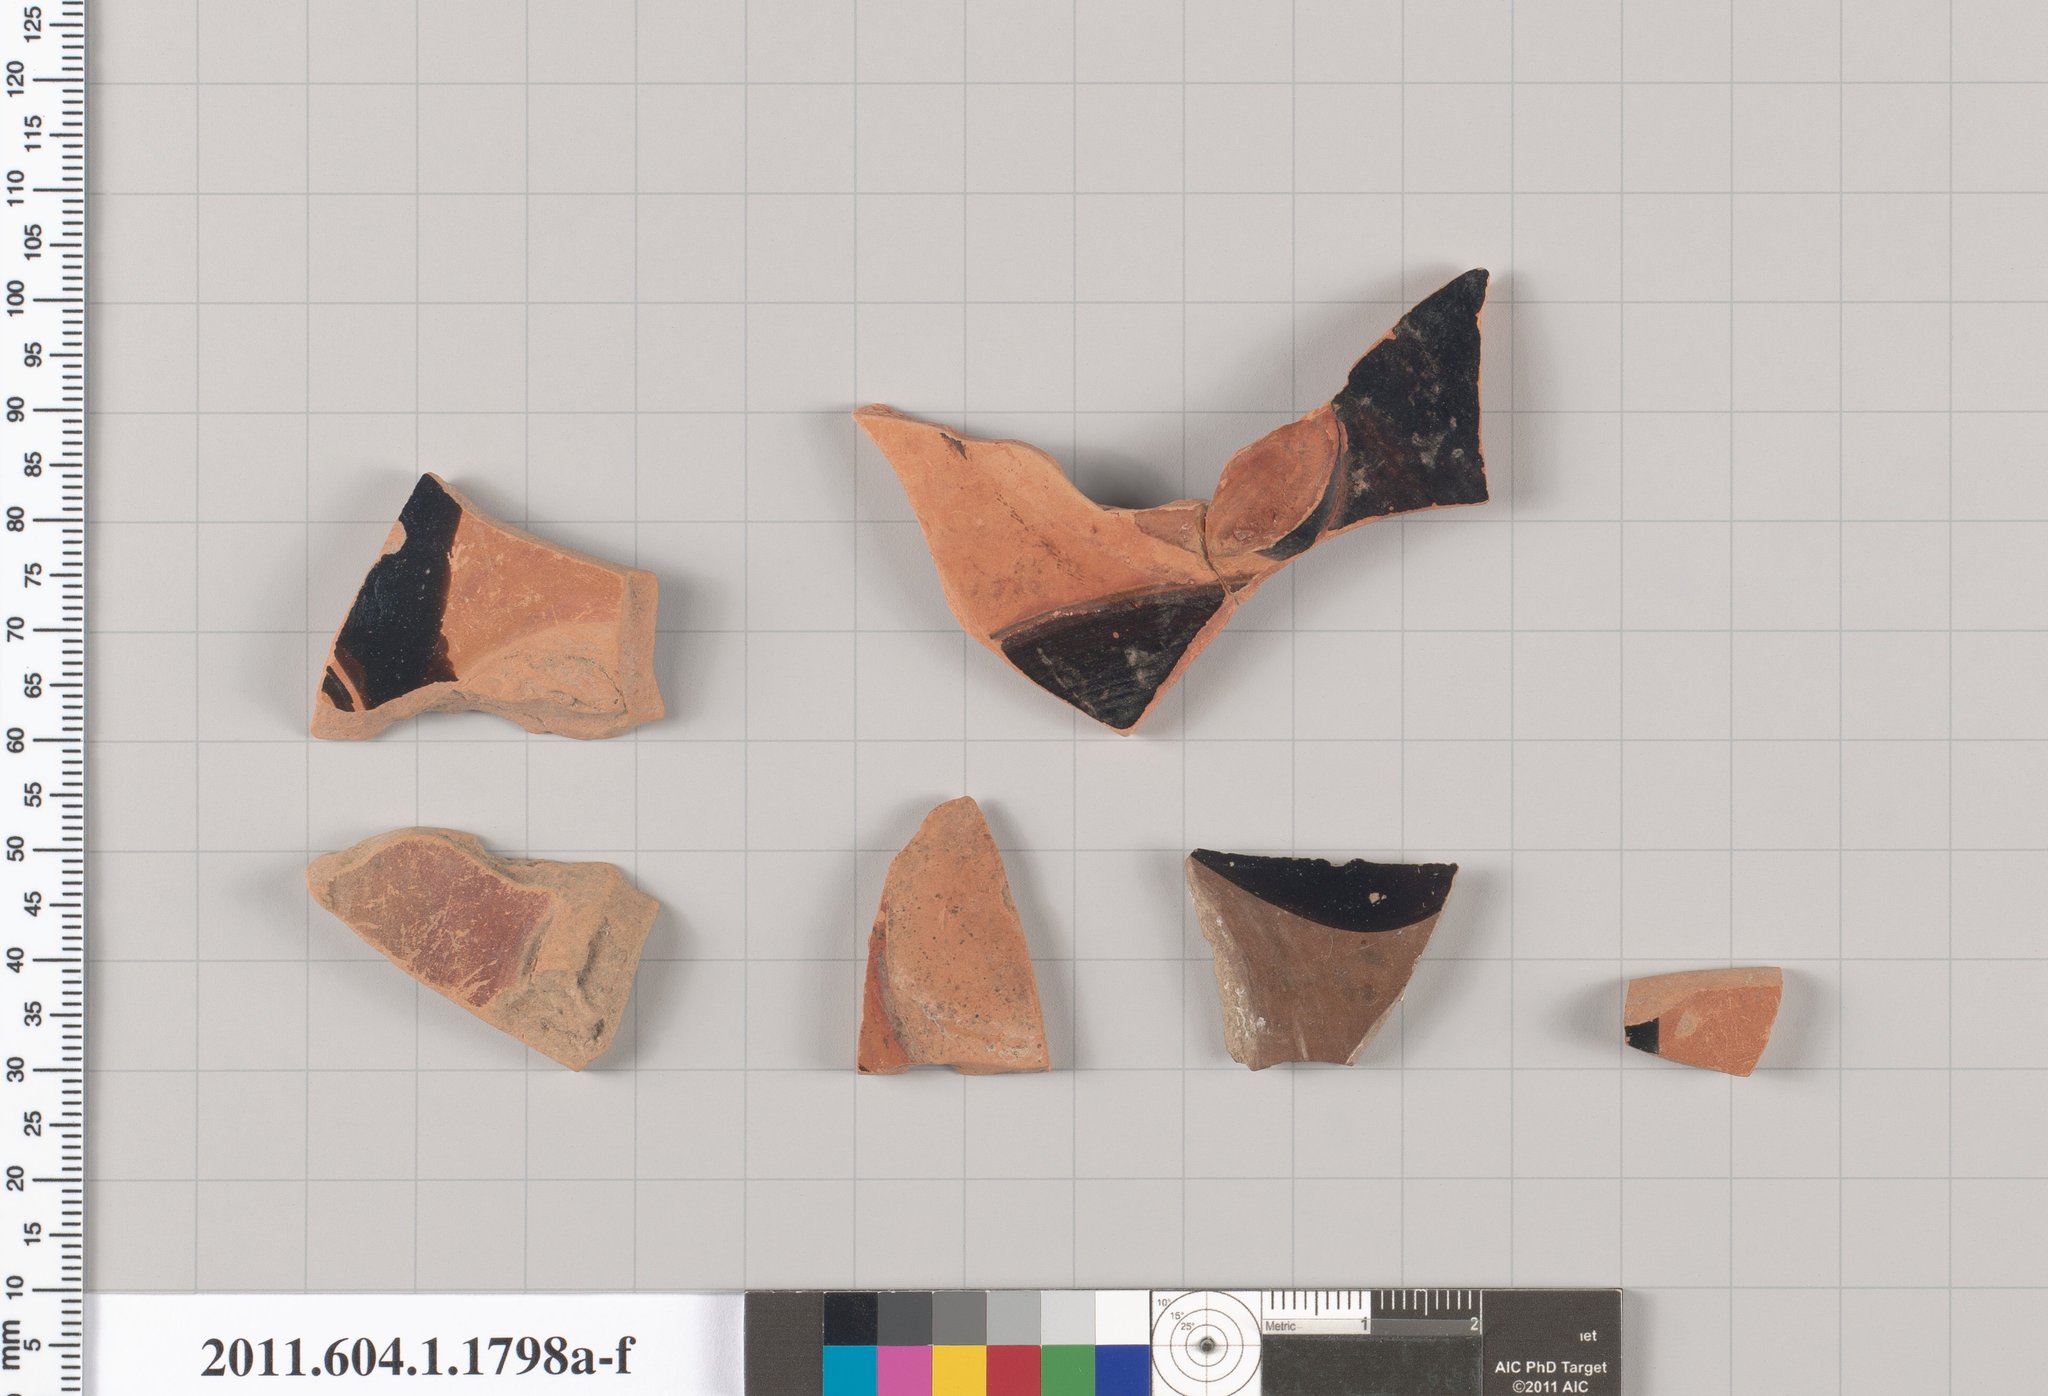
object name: kylix fragment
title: Terracotta rim fragments of kylikes(drinking cups)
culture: greek, attic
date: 500-401 BCE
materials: terracotta